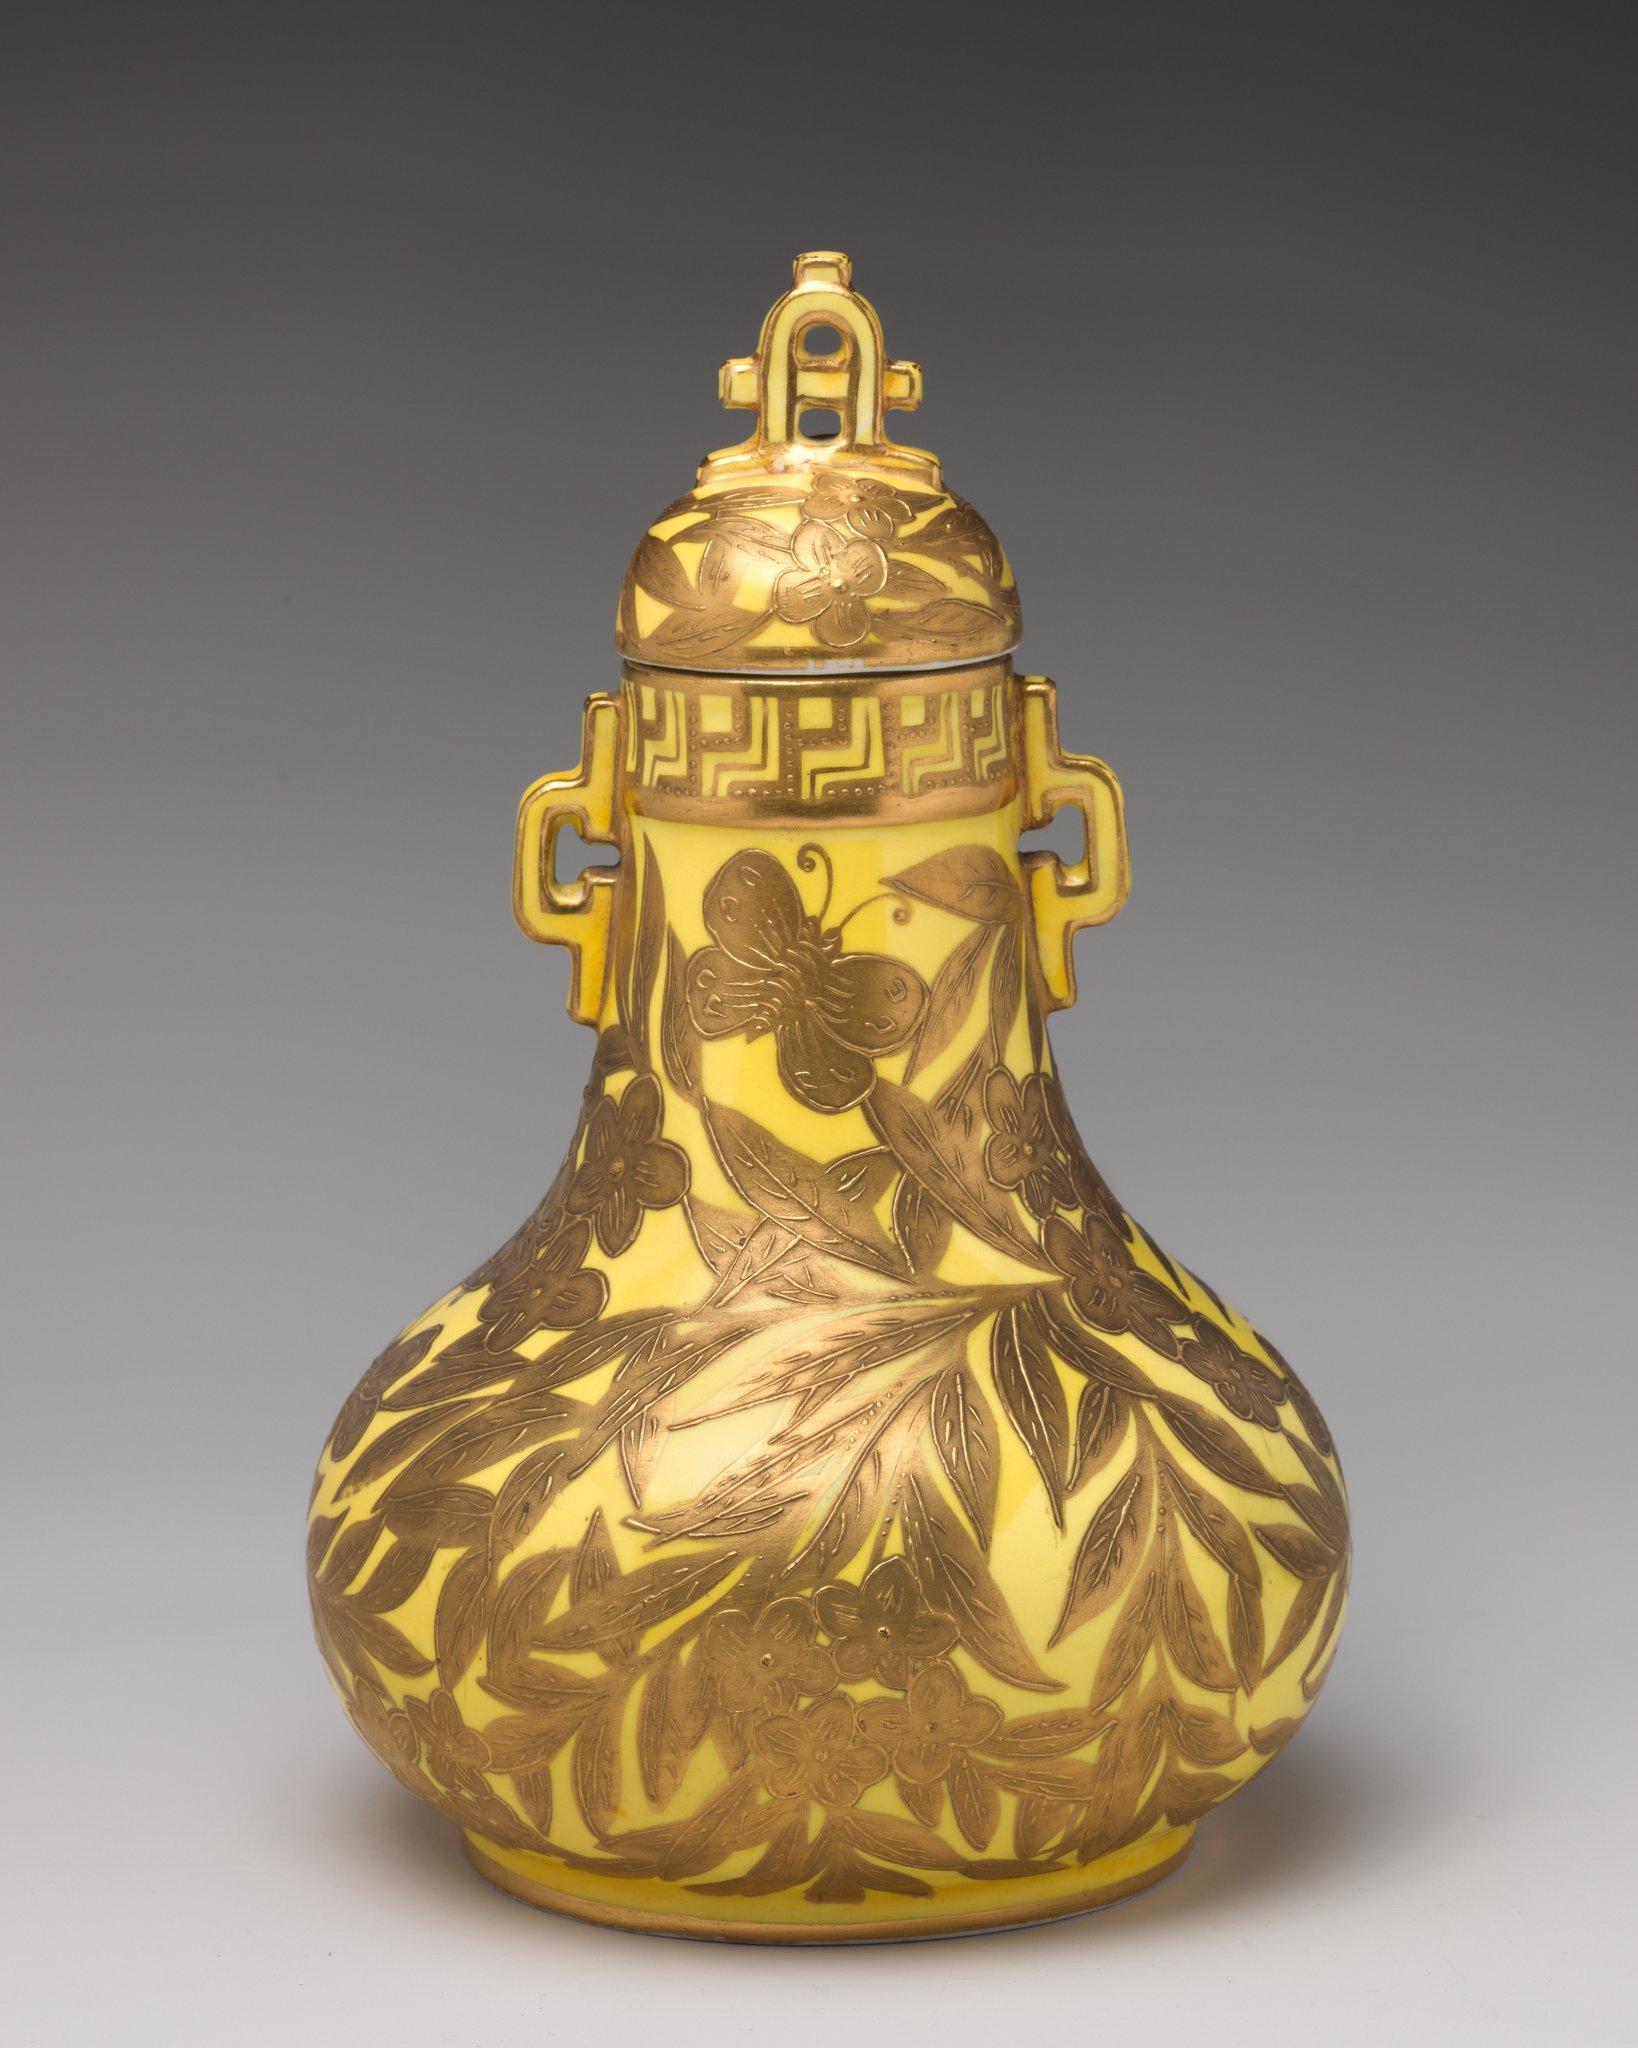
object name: lidded jar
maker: crown derby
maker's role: maker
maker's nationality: british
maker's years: 1750-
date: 1877-1882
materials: porcelain